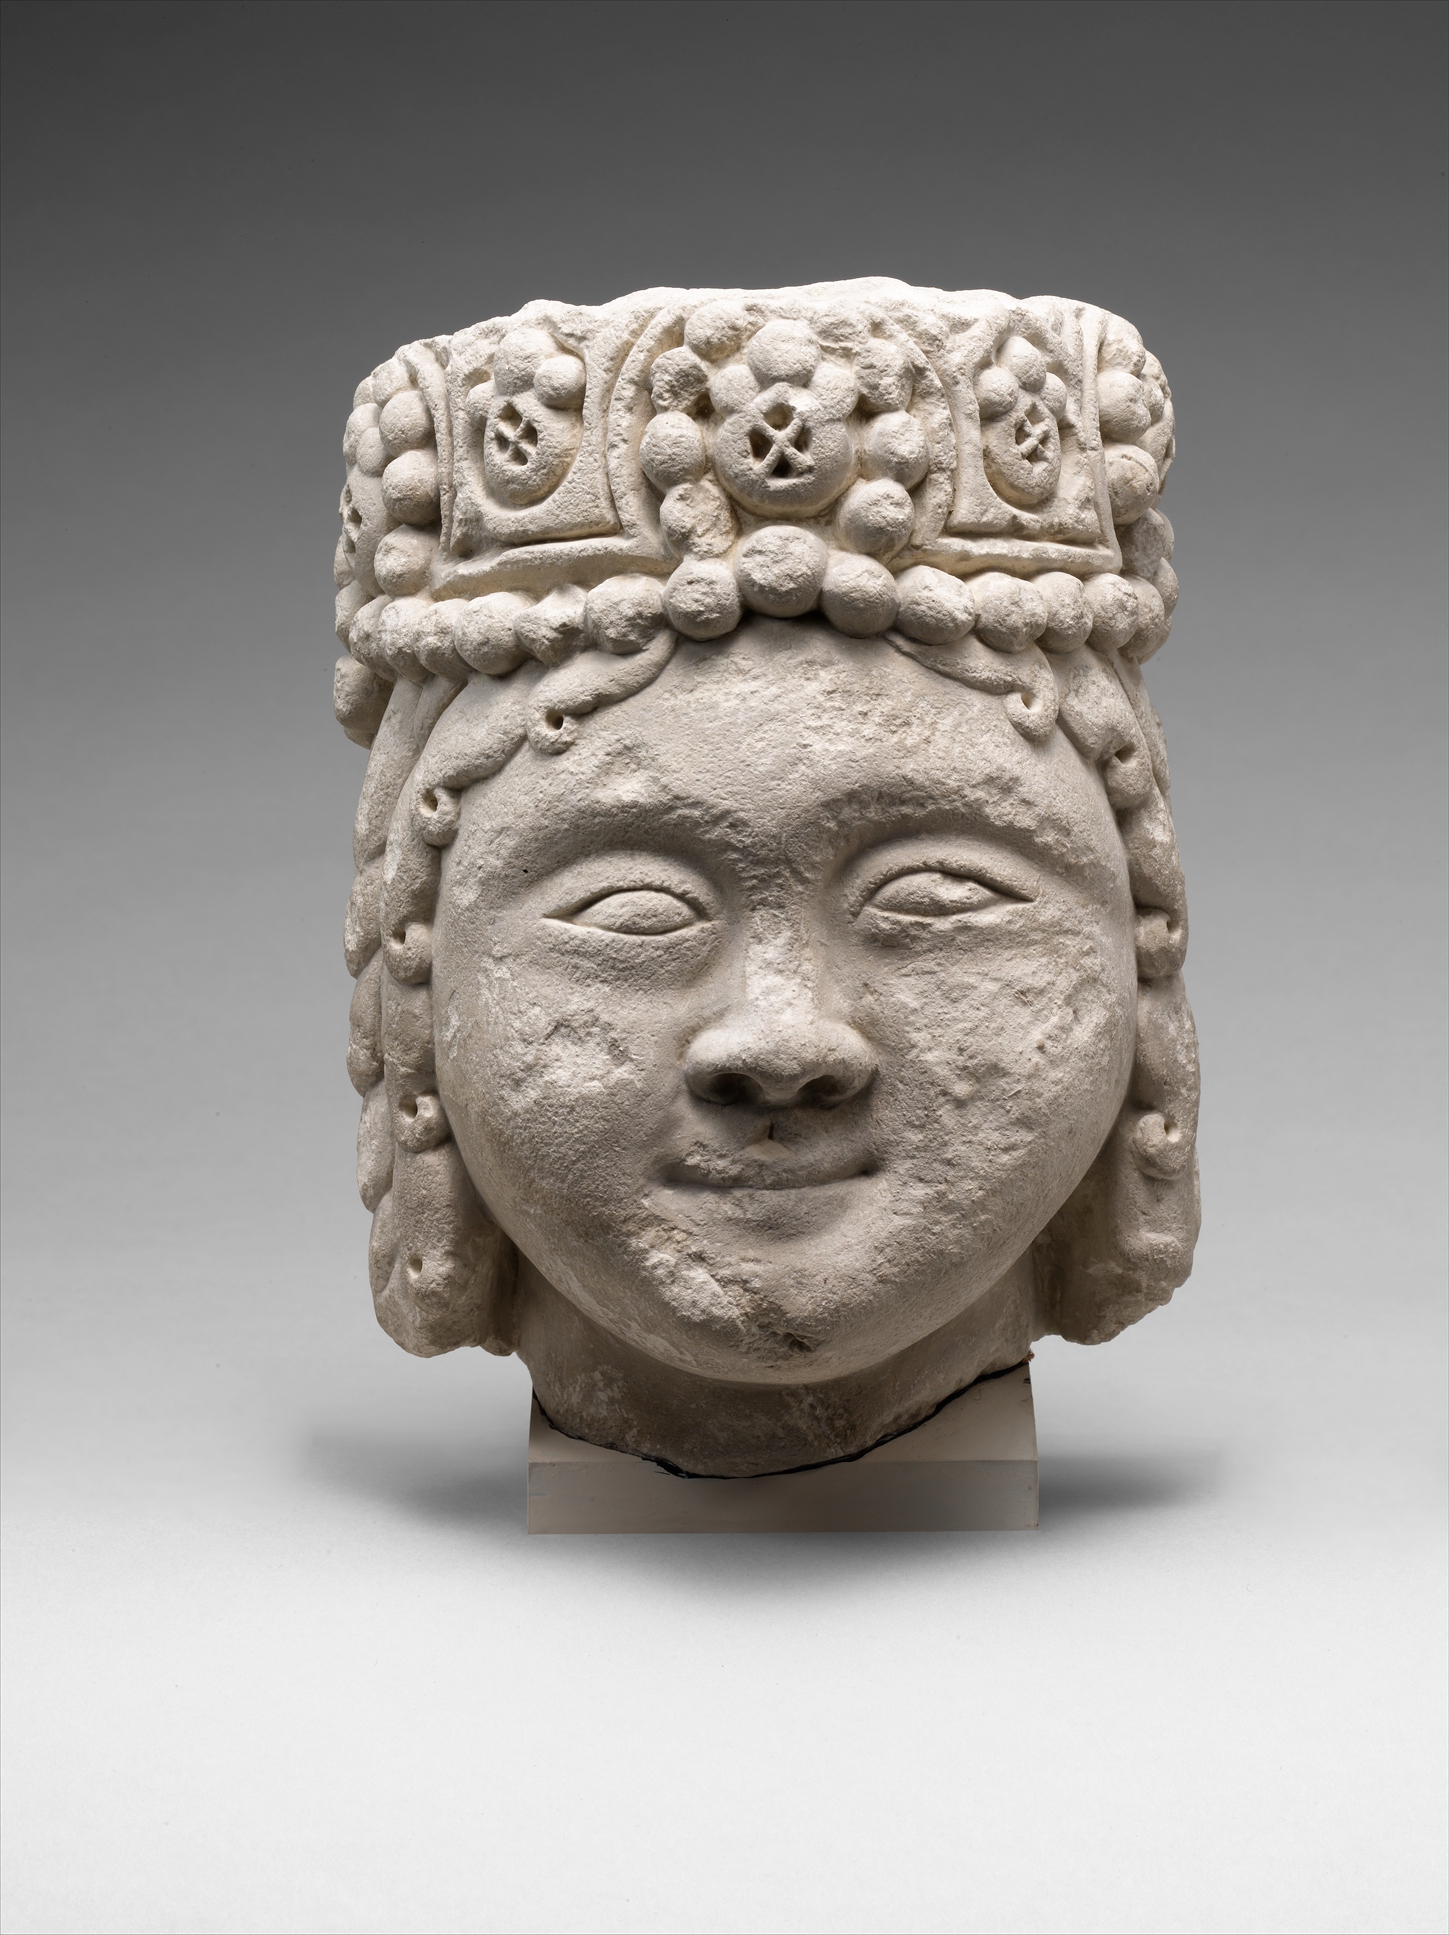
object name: head of a figure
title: Head from a Figure with a Beaded Headdress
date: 1101-1233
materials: limestone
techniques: carving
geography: iran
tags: heads